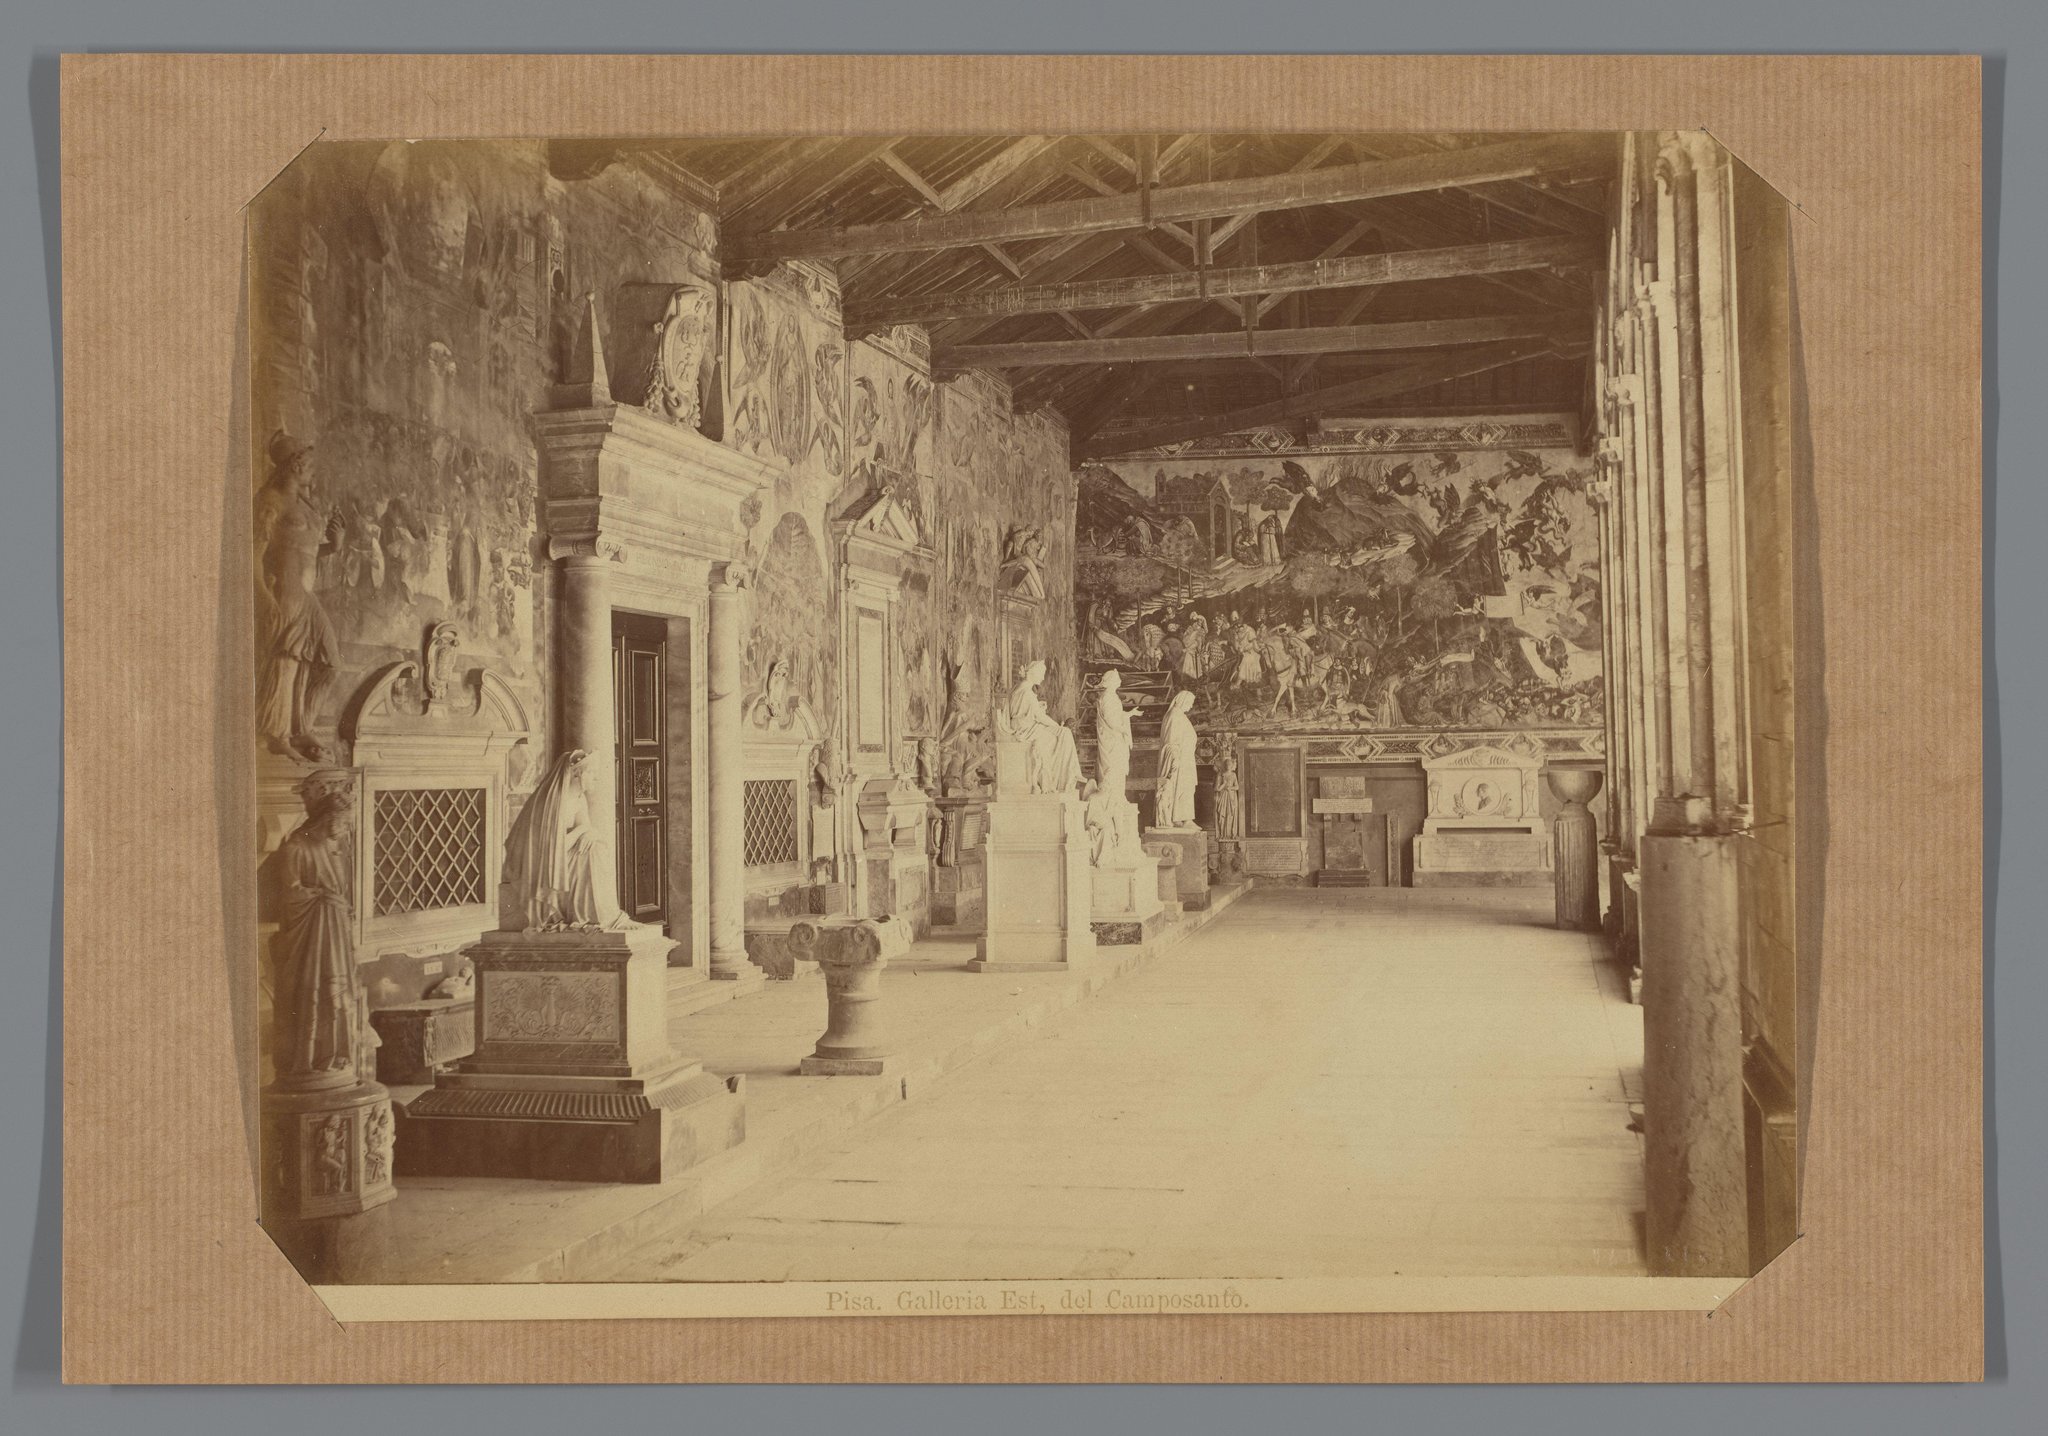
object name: photograph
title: Italië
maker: Anonymous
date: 1880-1910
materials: photographic support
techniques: albumen print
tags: italy